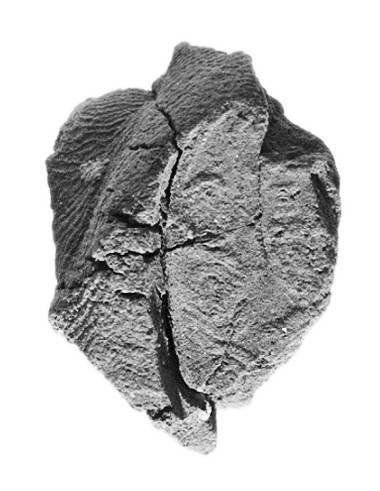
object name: sealing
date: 1981-1640 BCE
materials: mud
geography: egypt